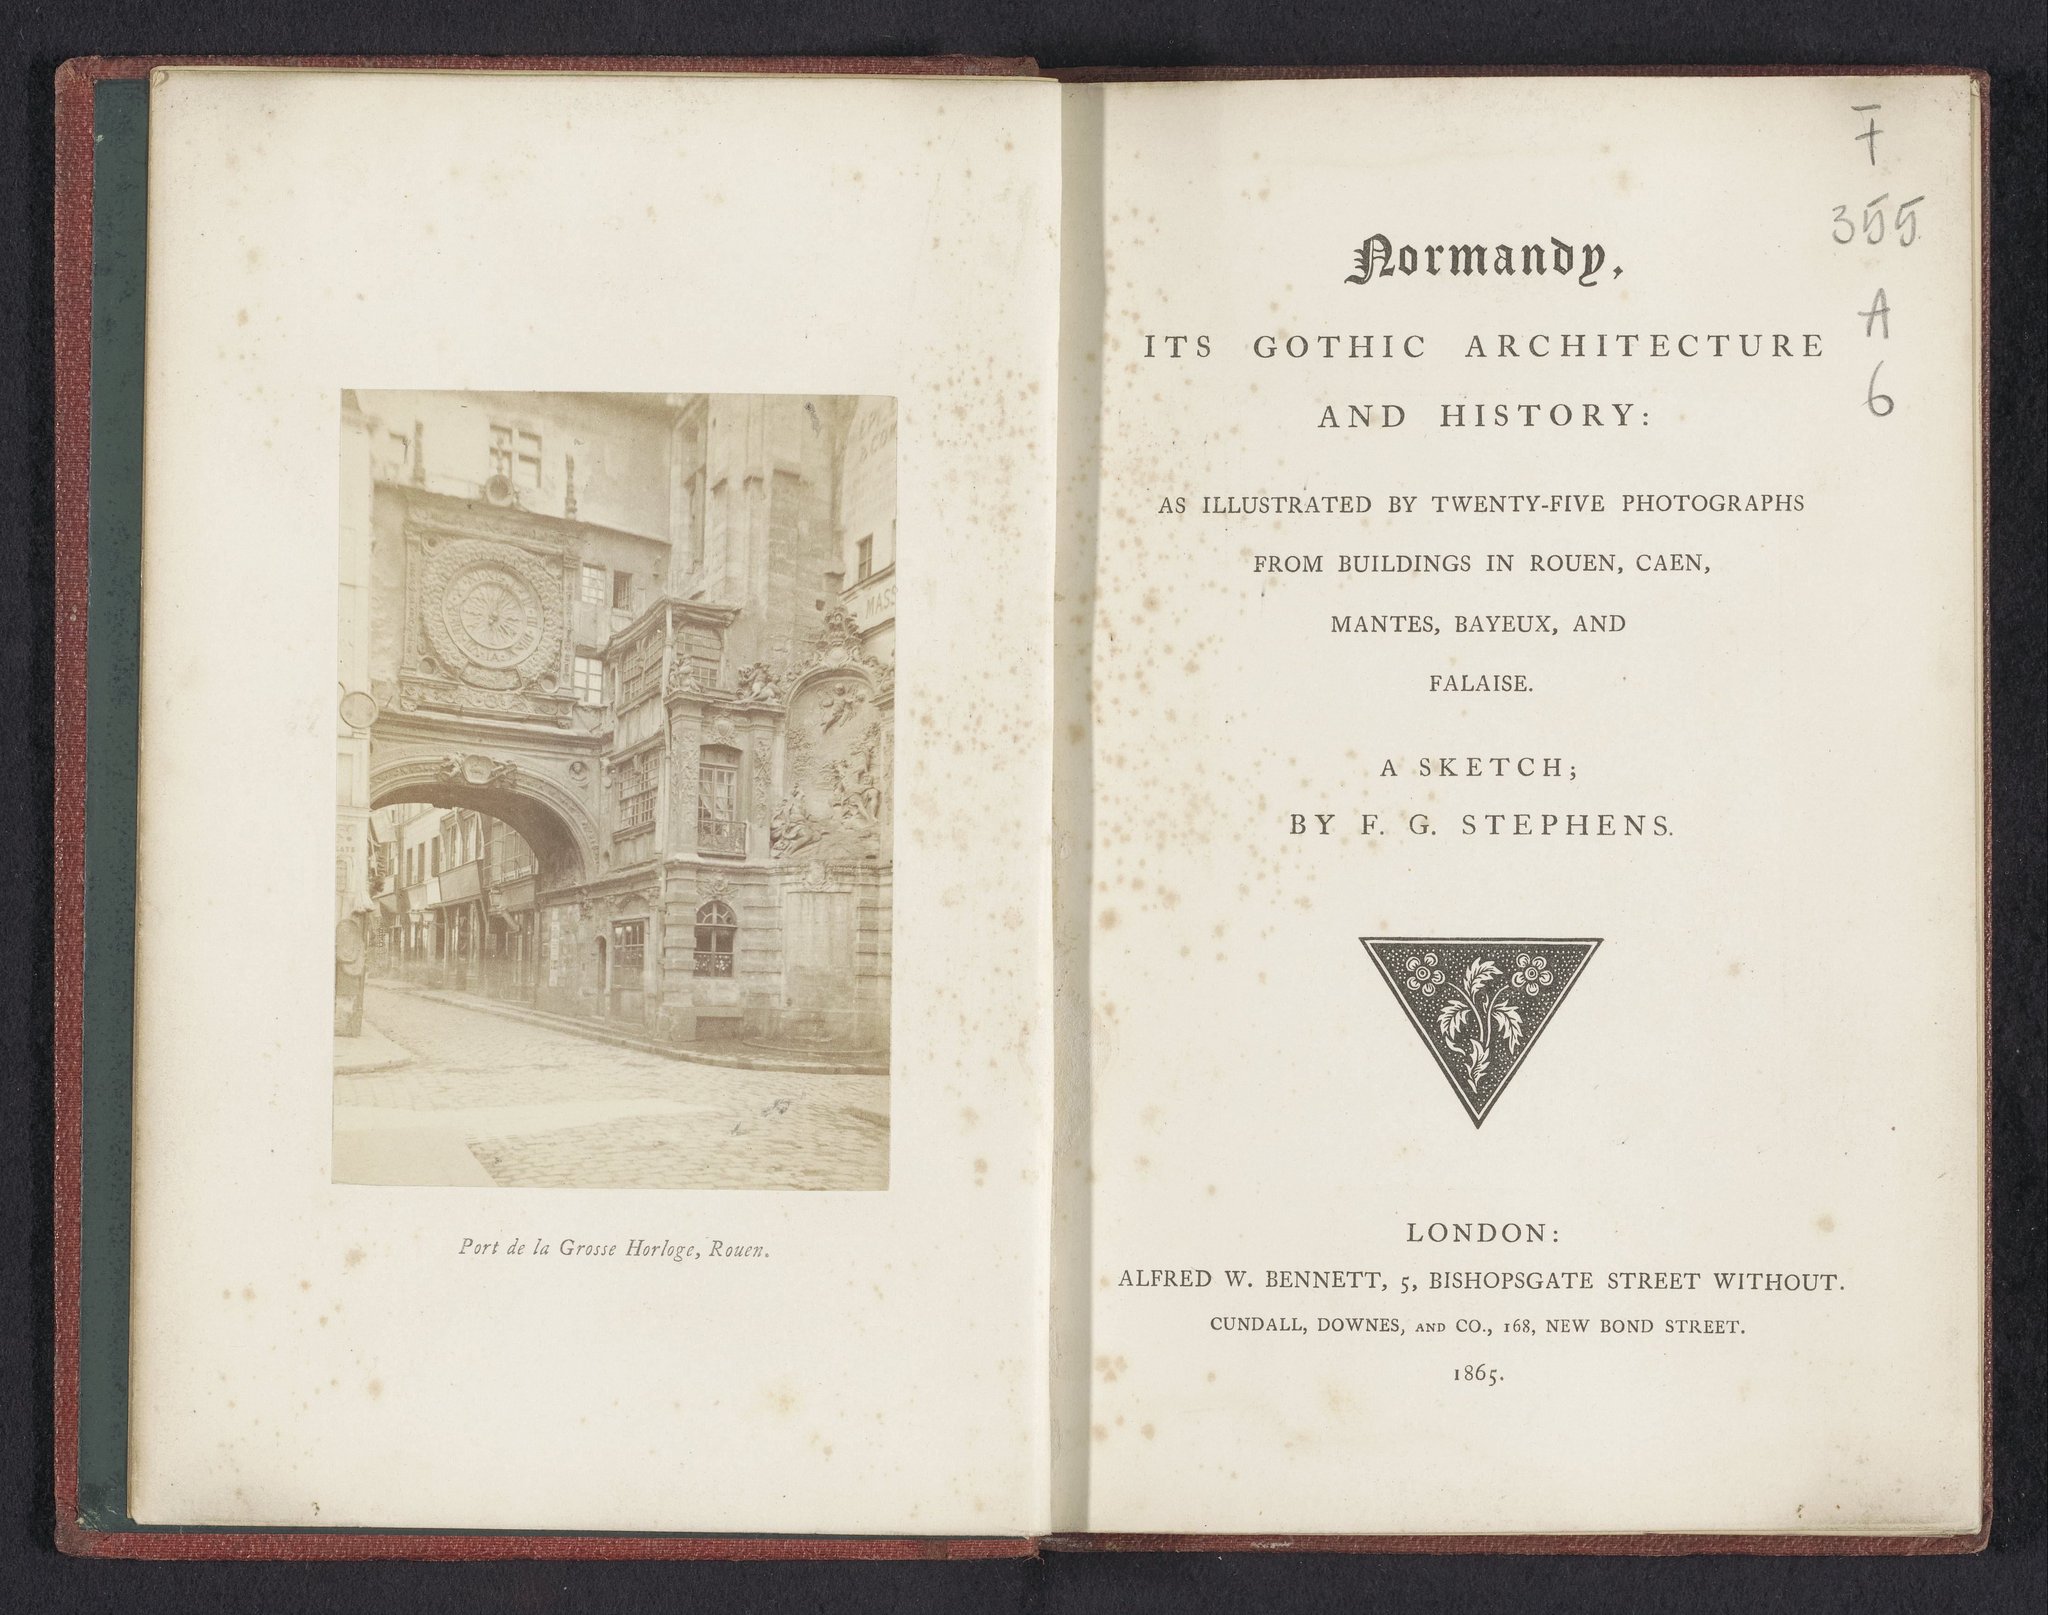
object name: book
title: Normandy, its gothic architecture and history, as illustrated by twenty-five photographs from buildings in Rouen, Caen, Nantes, Bayeux, and Falaise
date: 1865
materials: linen, paper, photographic support, wood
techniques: albumen print, printing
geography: london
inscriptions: name: ‘Hugh Parnell’